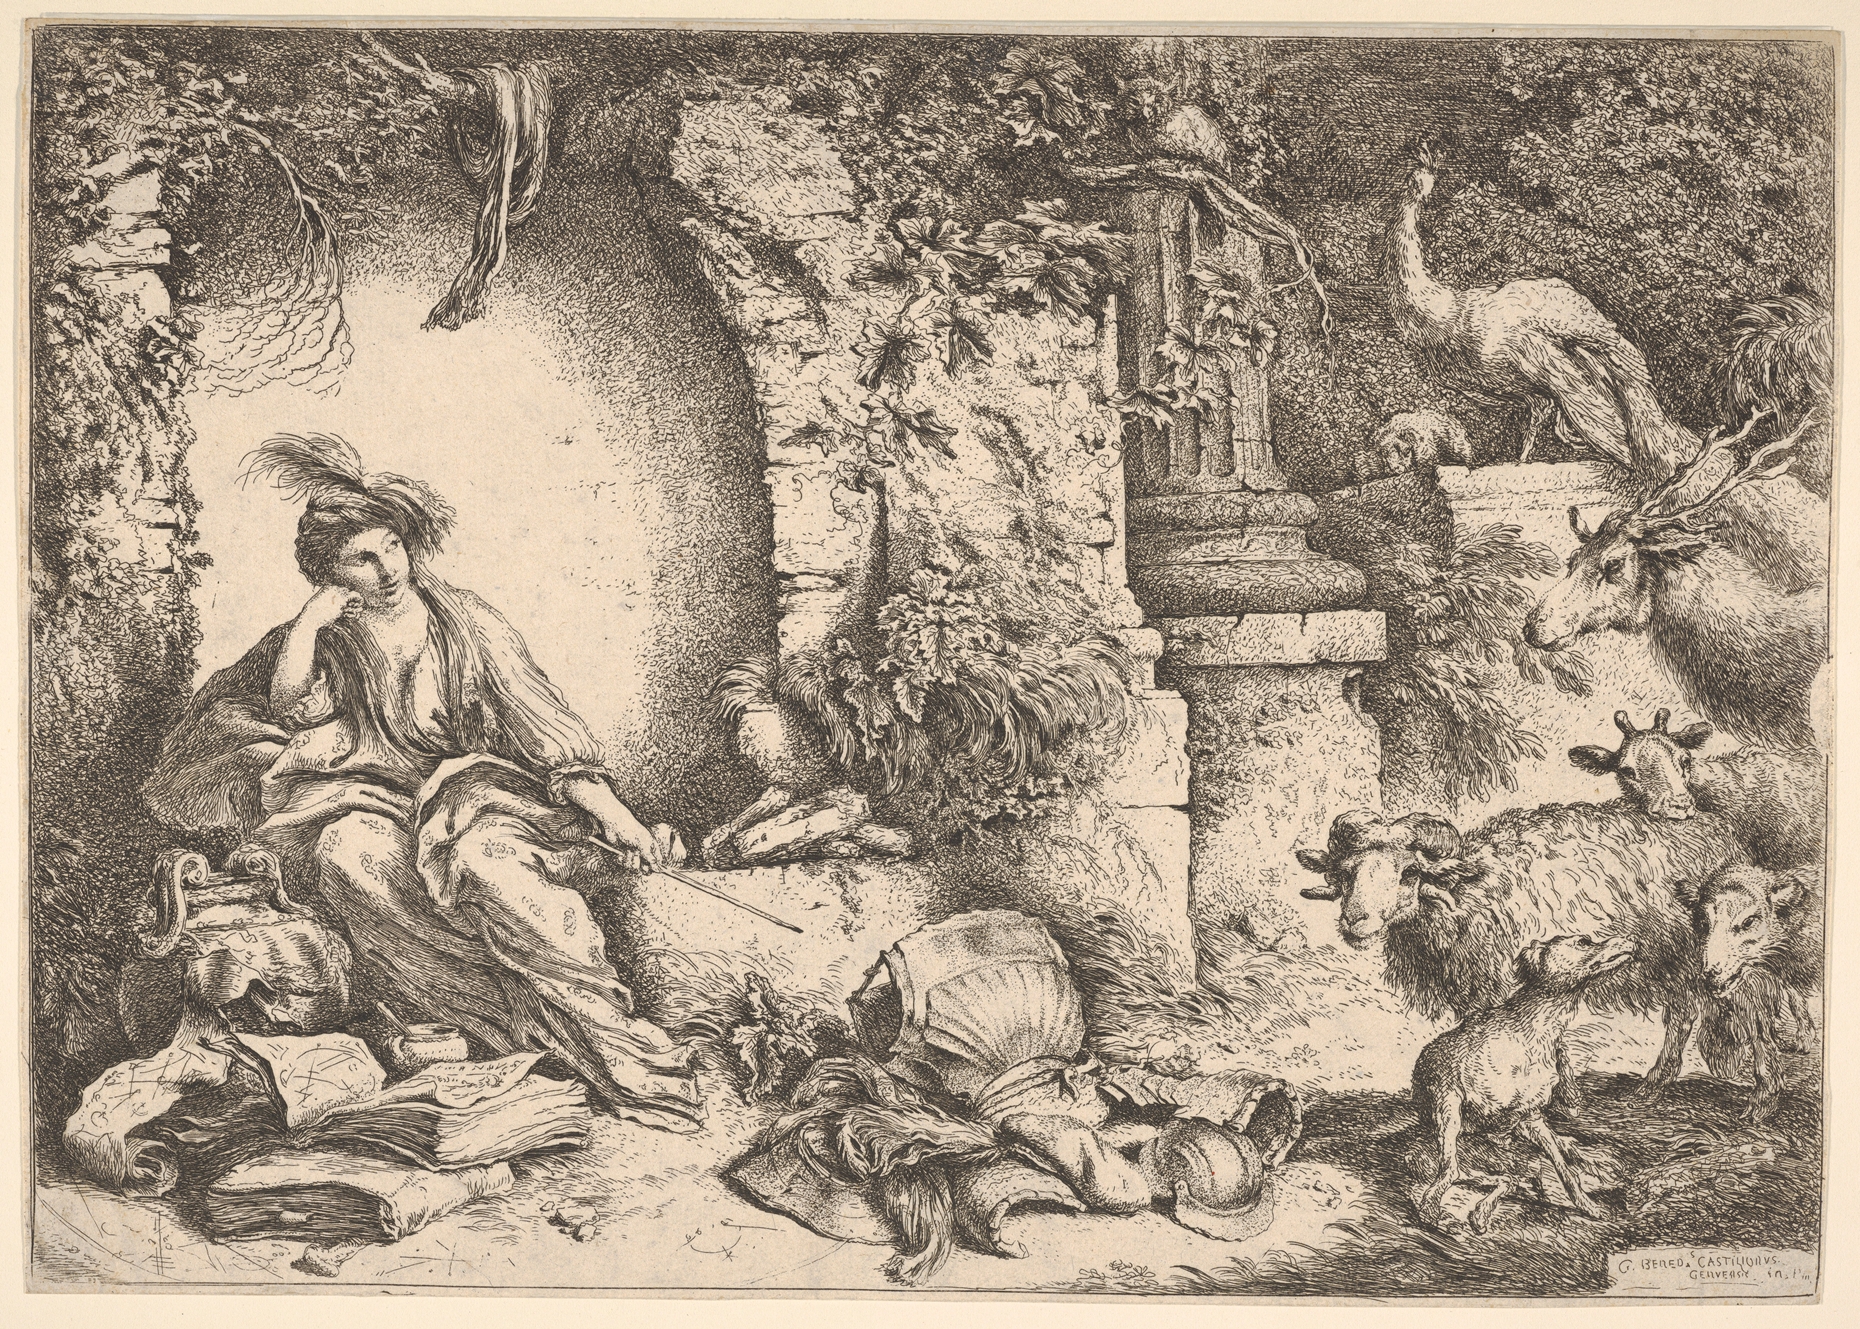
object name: print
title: Circe changing the companions of Ulysses into beasts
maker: giovanni benedetto castiglione (il grechetto)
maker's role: artist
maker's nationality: italian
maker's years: 1609-1664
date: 1650-1651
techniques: etching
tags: women,peacocks,deer,sheep